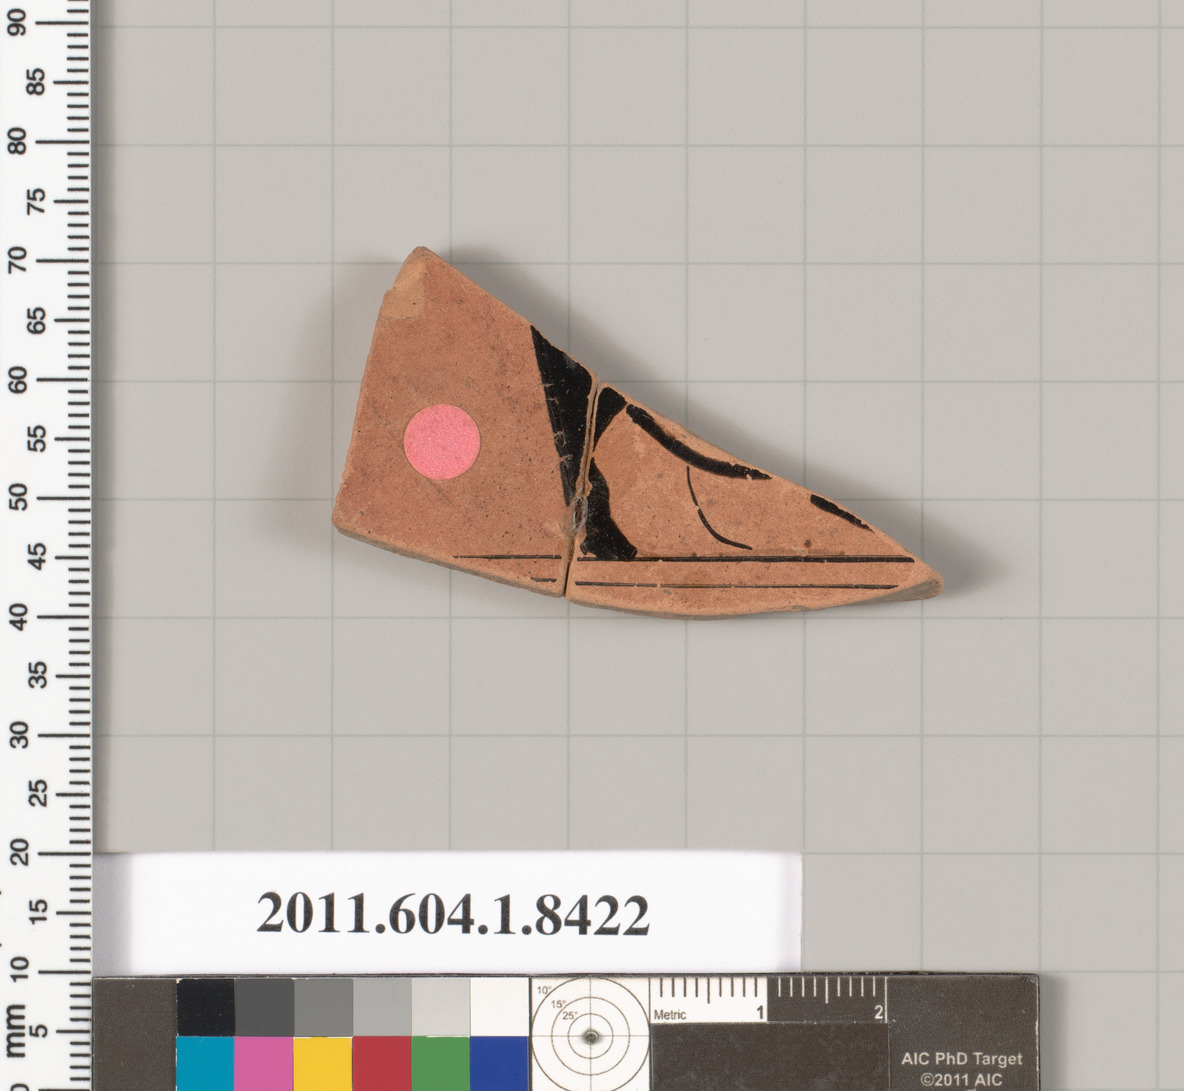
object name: kylix fragment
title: Terracotta fragment of a kylix (drinking cup)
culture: greek, attic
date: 434-401 BCE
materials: terracotta